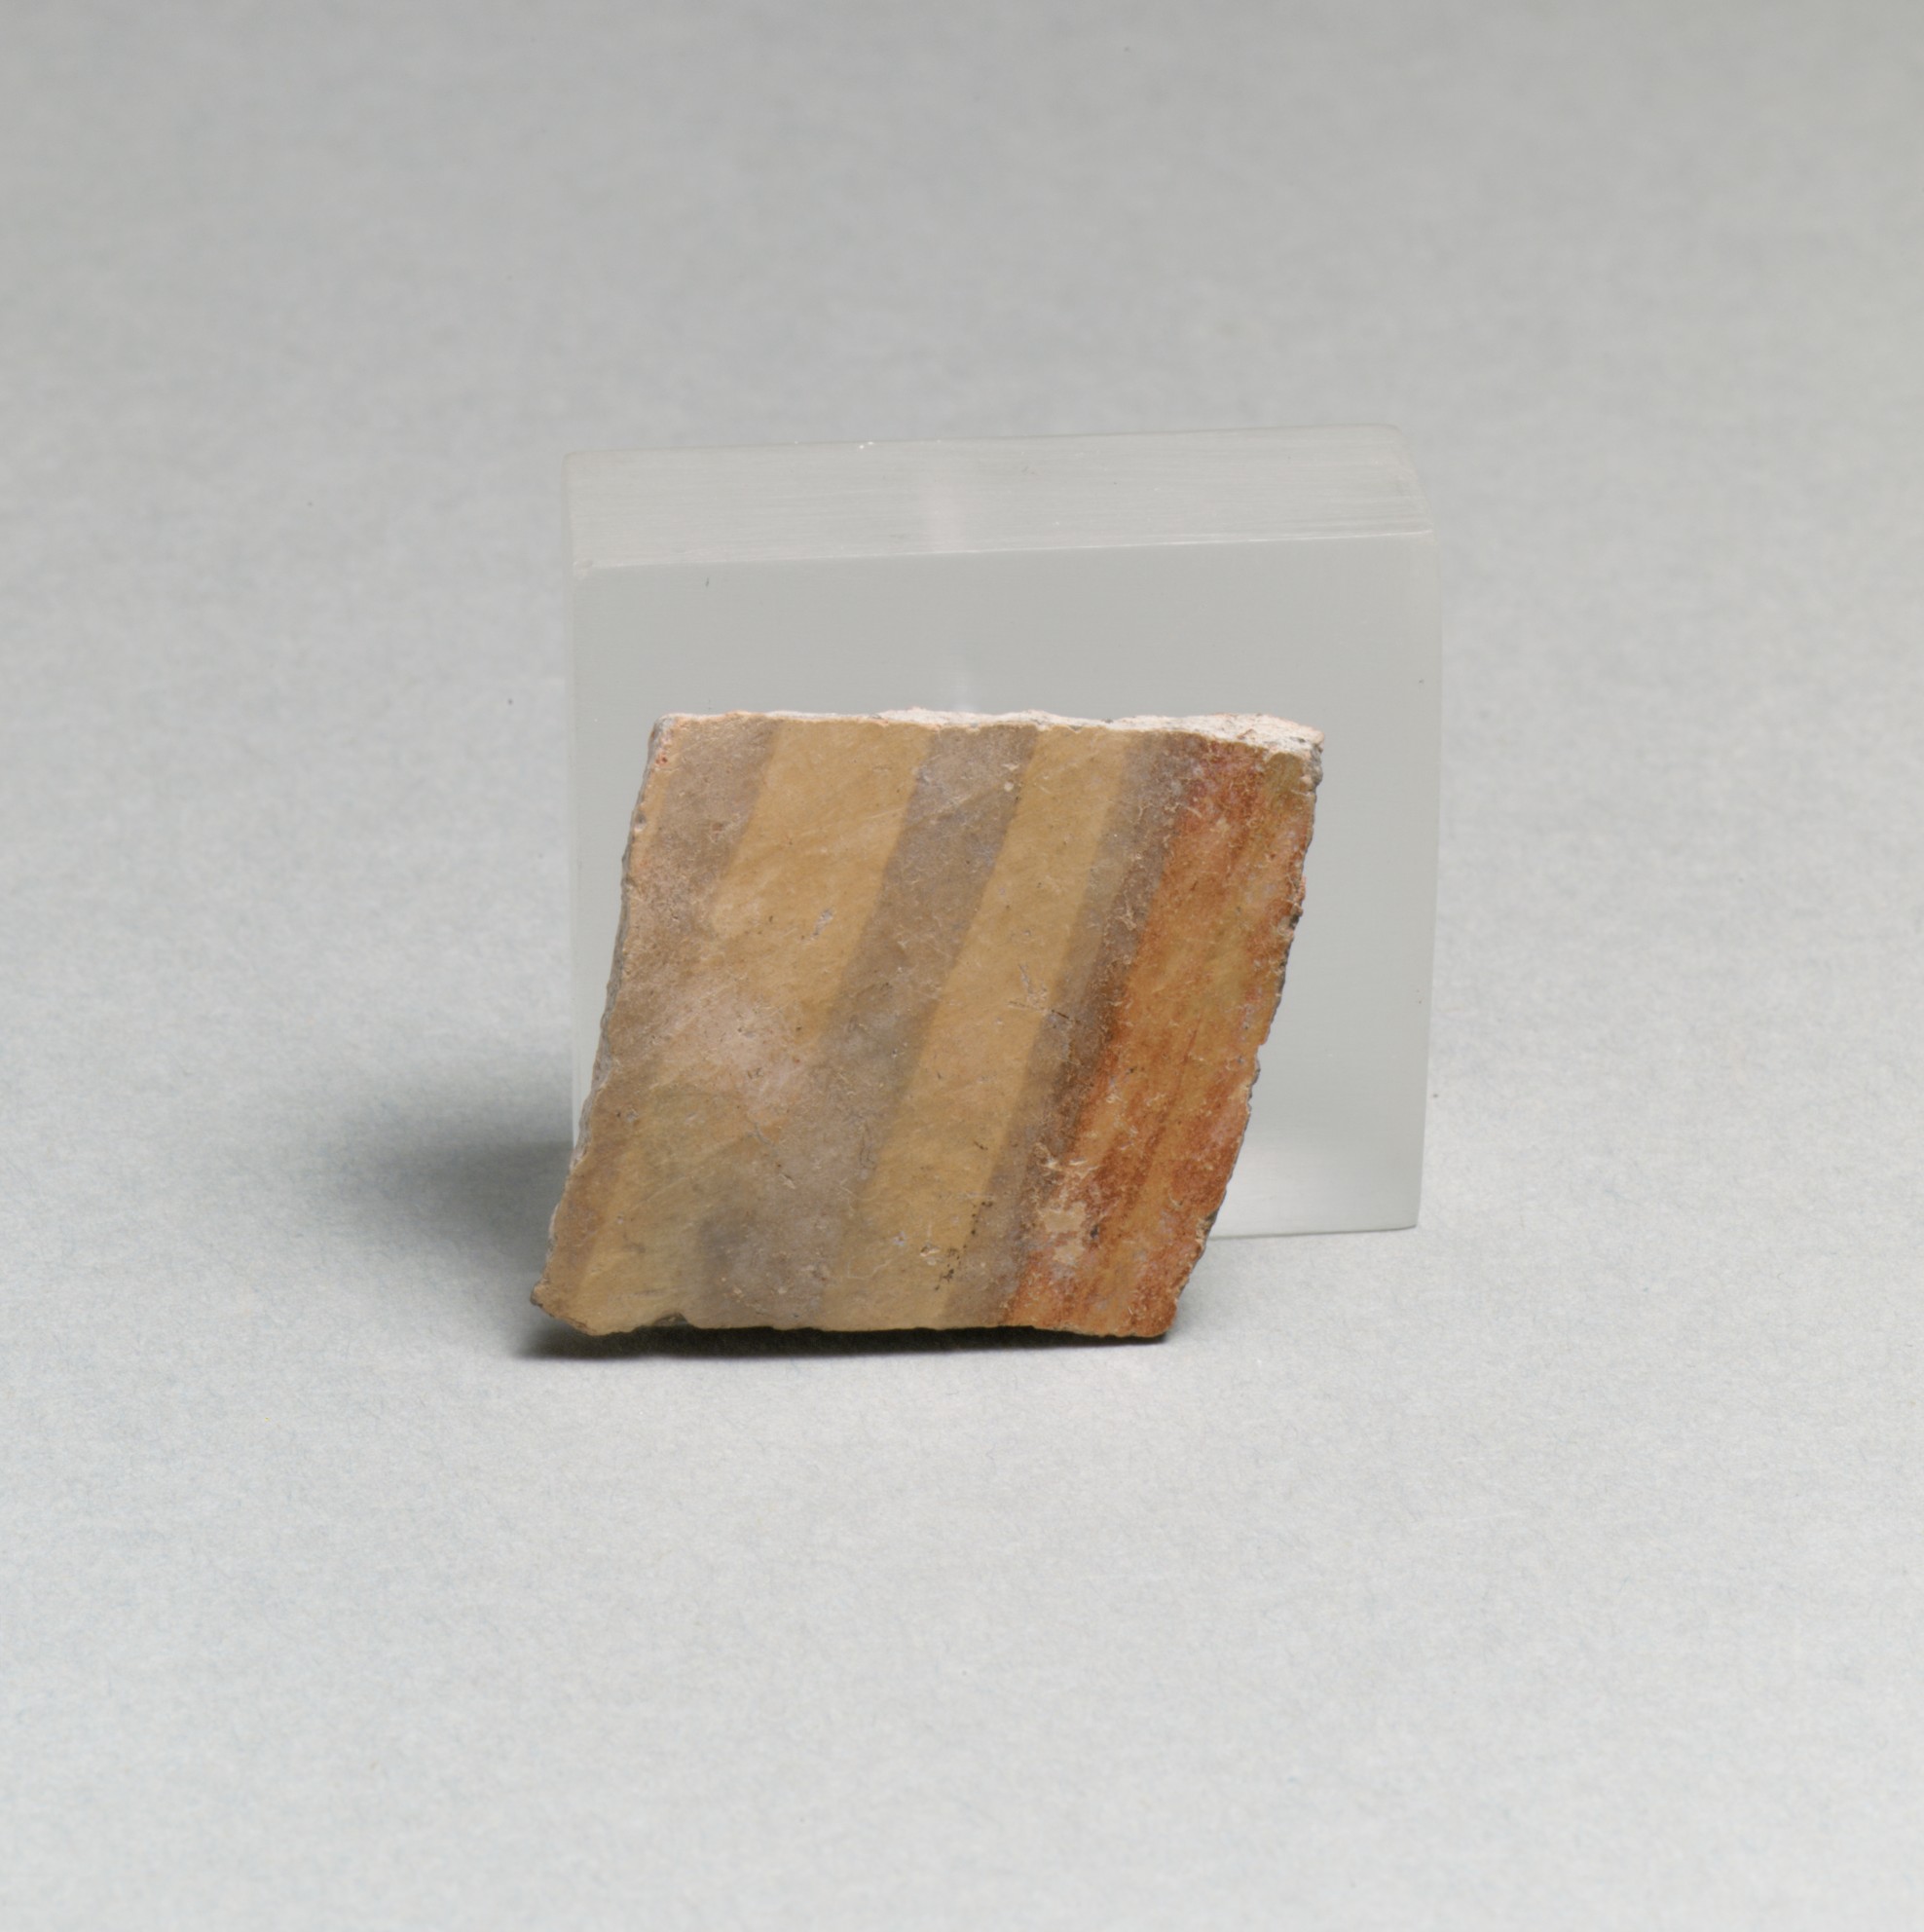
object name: vase fragment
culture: neolithic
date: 4000-3000 BCE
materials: terracotta